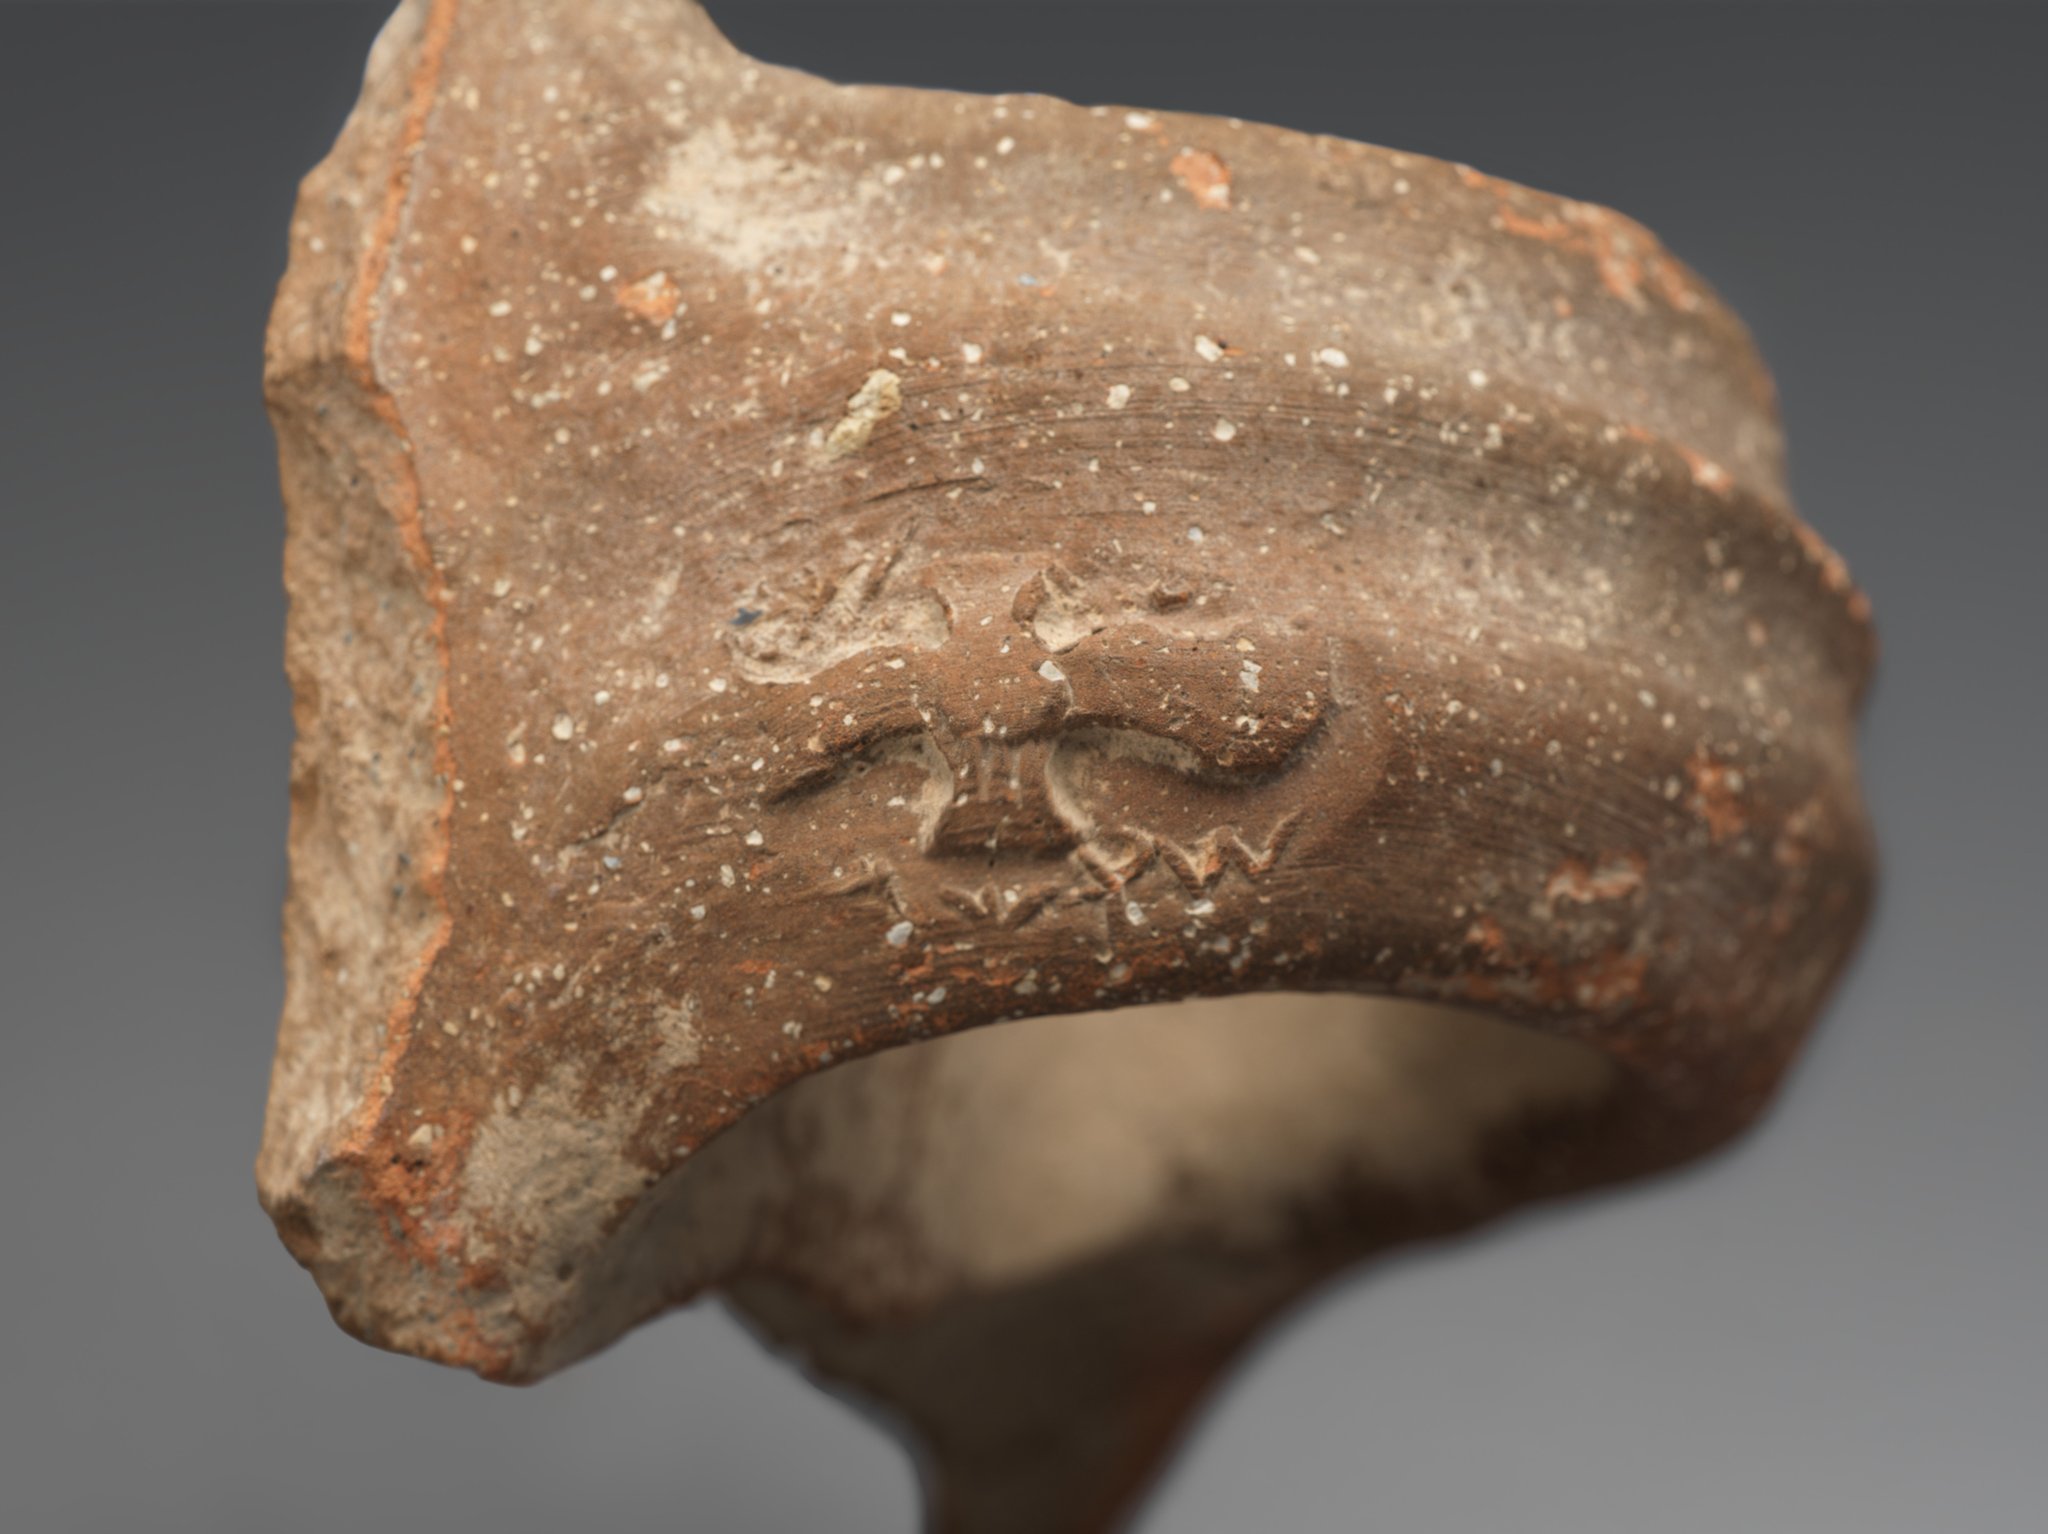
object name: jar with handle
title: Jar handle with seal impression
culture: israelite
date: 734-601 BCE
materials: ceramic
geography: levant